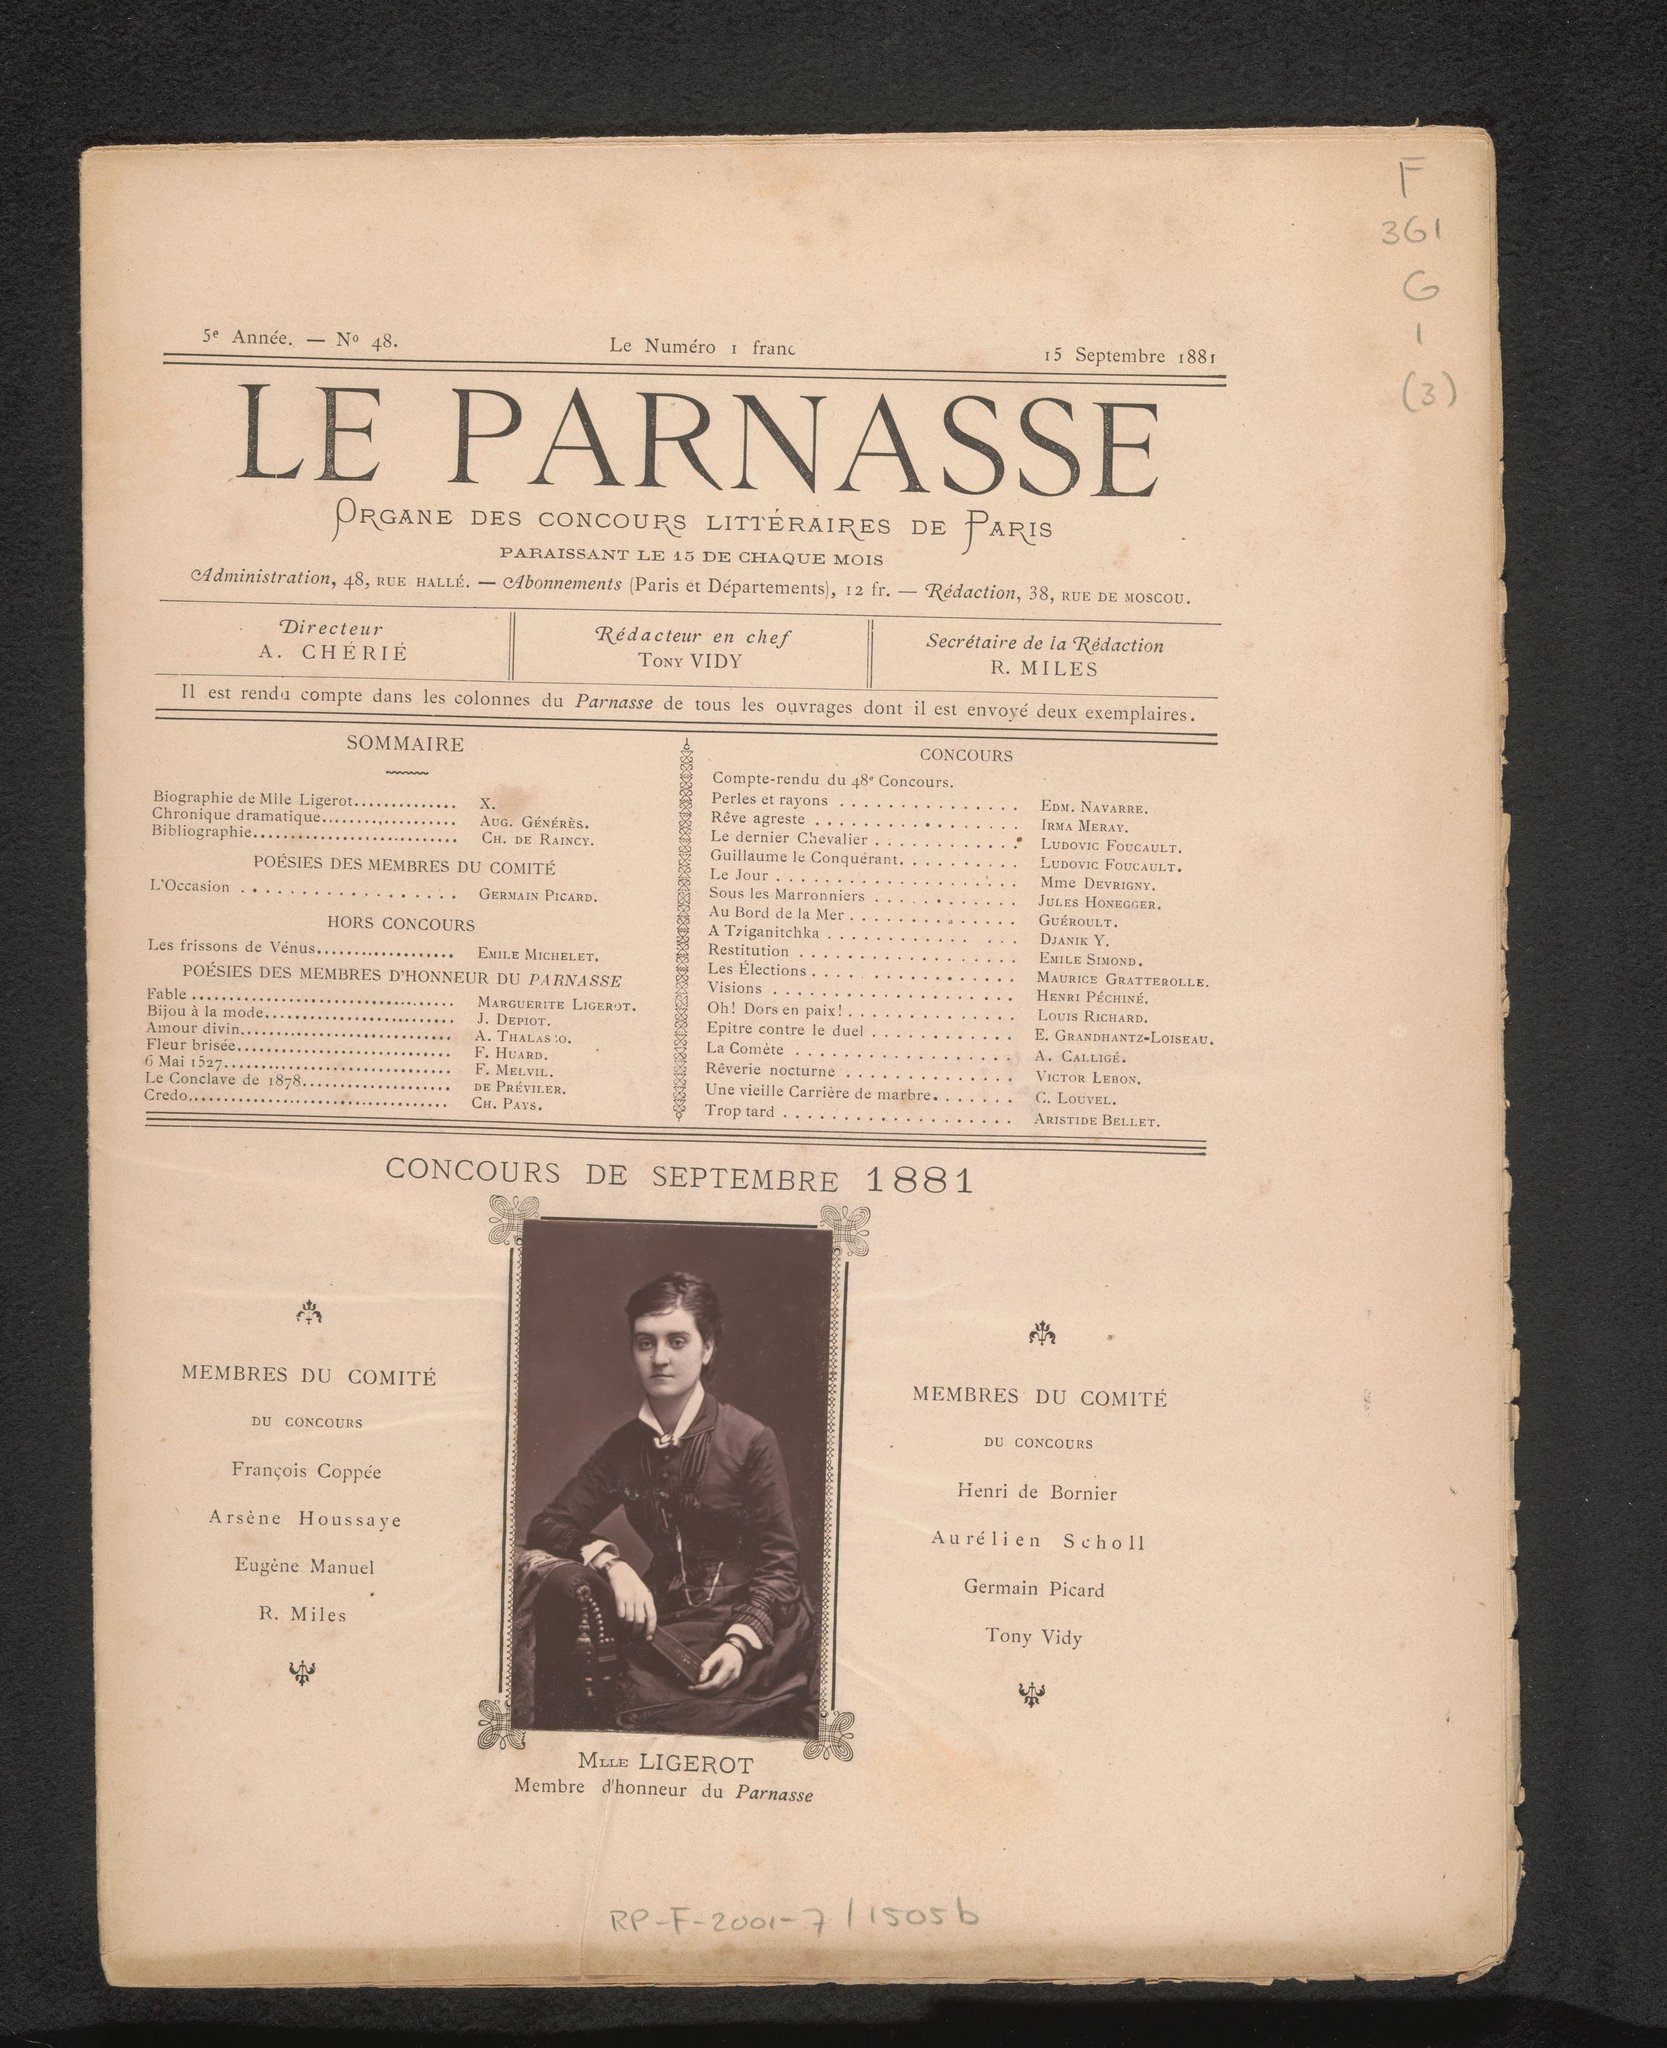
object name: magazine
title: Le parnasse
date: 1881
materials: paper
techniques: printing, woodburytype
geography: l'aigle